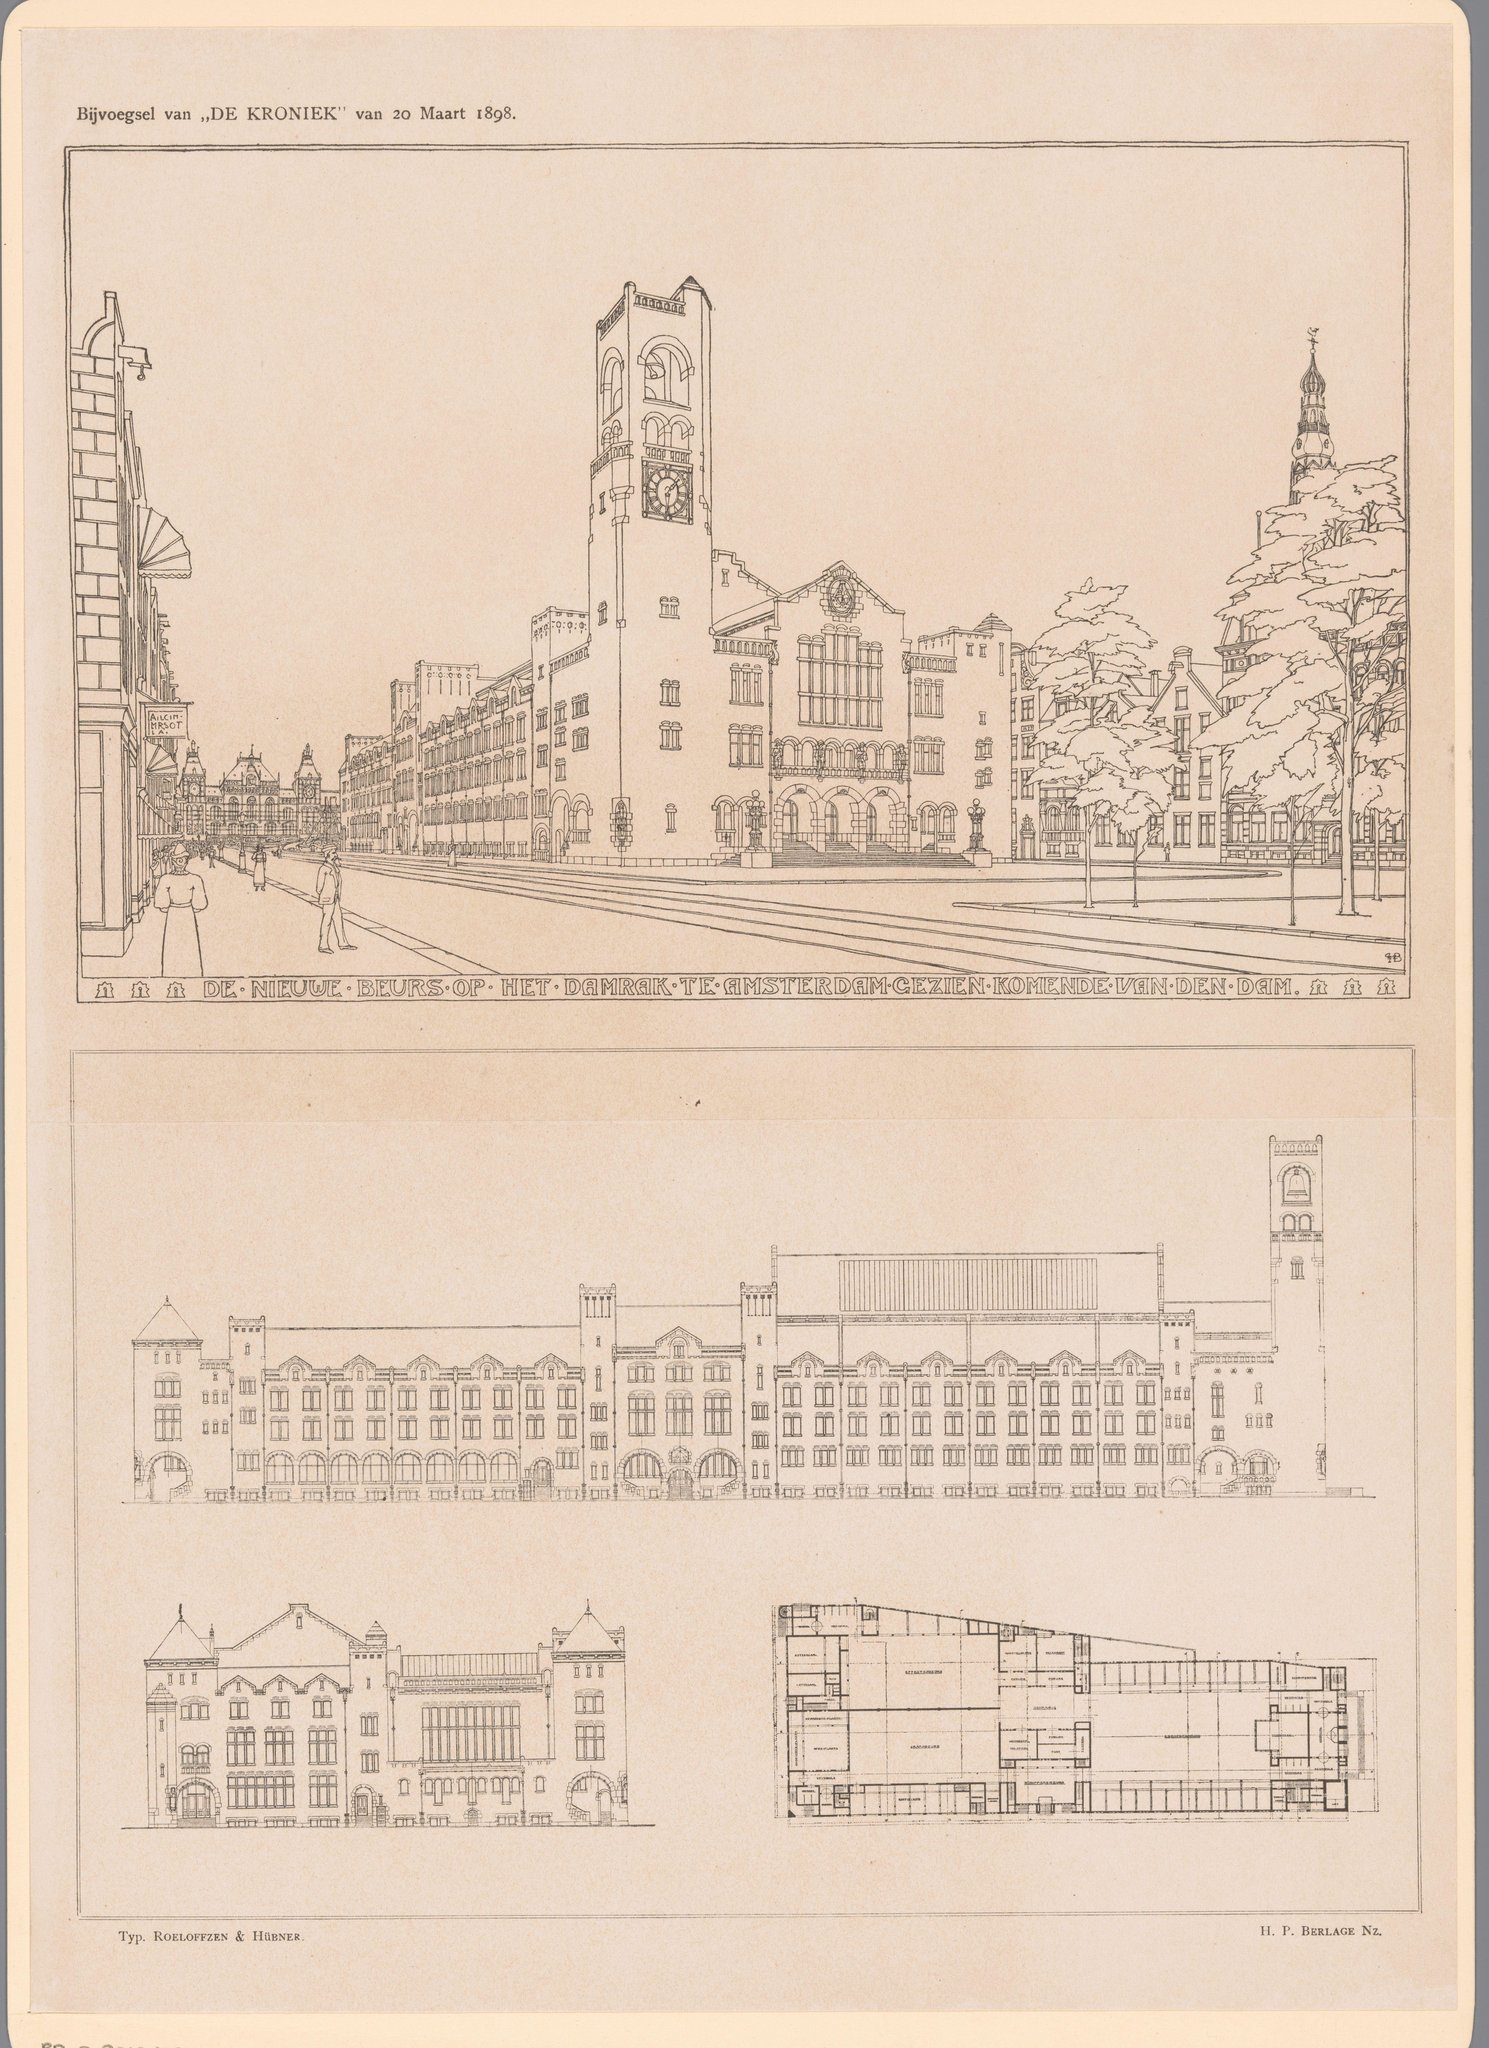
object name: book illustration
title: Gezicht en ontwerp van de Beurs van Berlage in Amsterdam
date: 1898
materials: paper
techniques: lithograph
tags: stock exchange, stock-market, market-hall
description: Deze prent was een zogeheten "Bijvoegsel" bij: De Kroniek 4 (1898), nr. 20 maart.